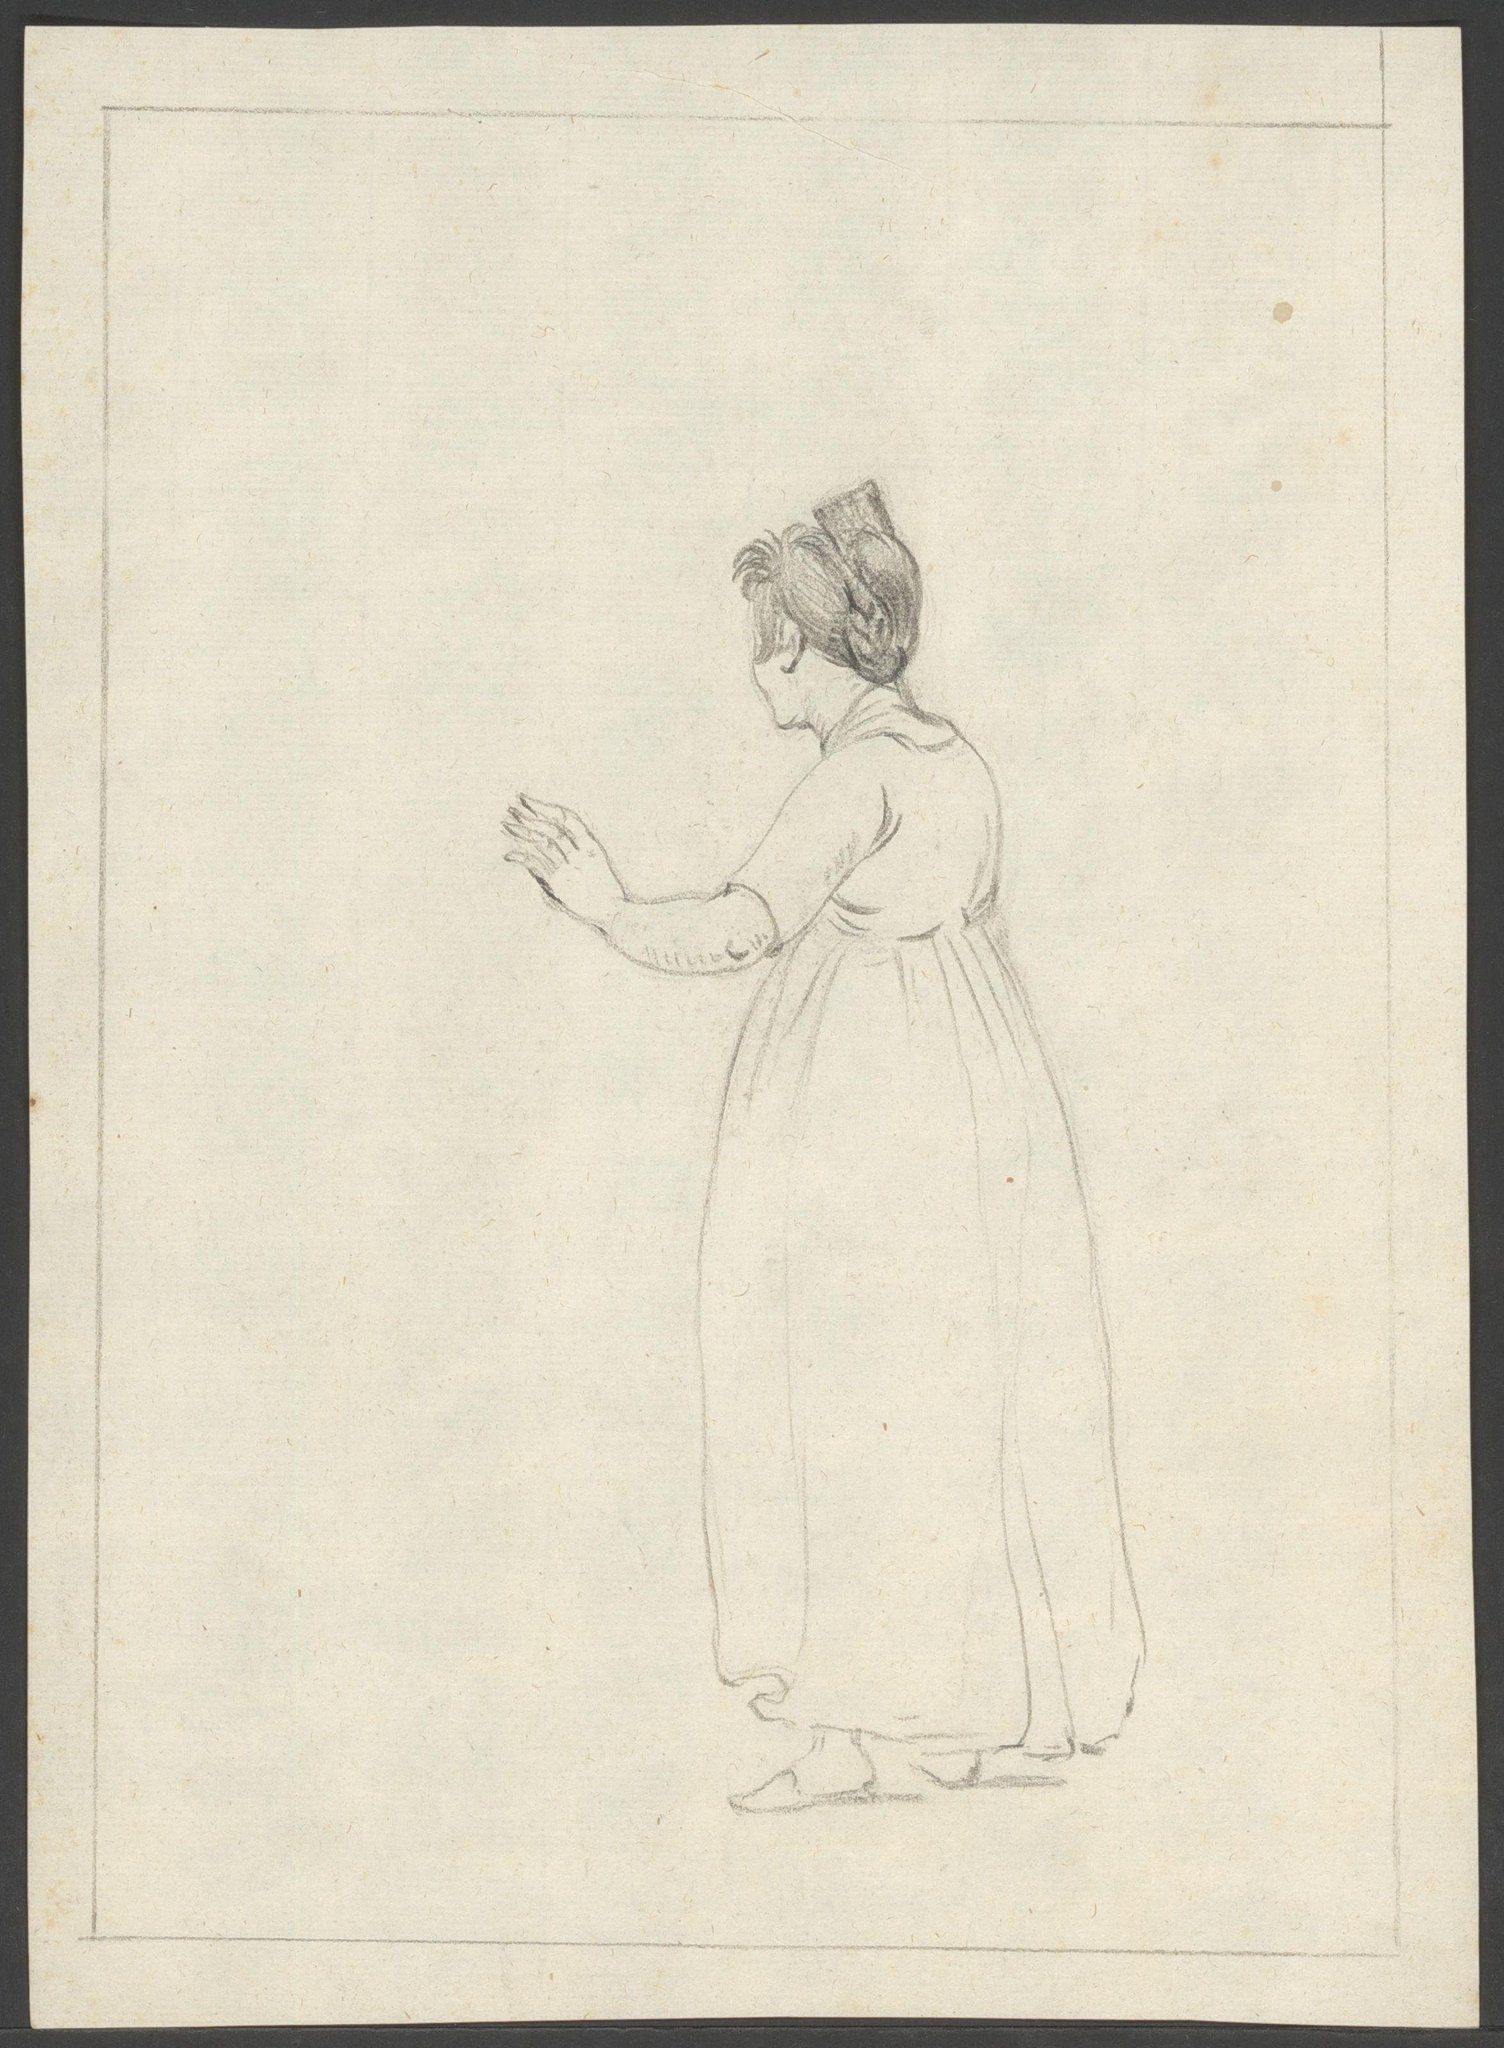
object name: drawing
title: Zwaaiende vrouw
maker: Anonymous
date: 1800-1899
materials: chalk, paper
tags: standing on one leg - aa - female human figure, waving farewell ~ departure on a journey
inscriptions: stamp, collector's mark: Lugt 1641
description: Zwaaiende vrouw op de rug gezien. Onderwerpsrubrieken binnen de Atlas Zeden en Gewoonten: Schoone kunsten, Schilderkunst, Tekeningen.